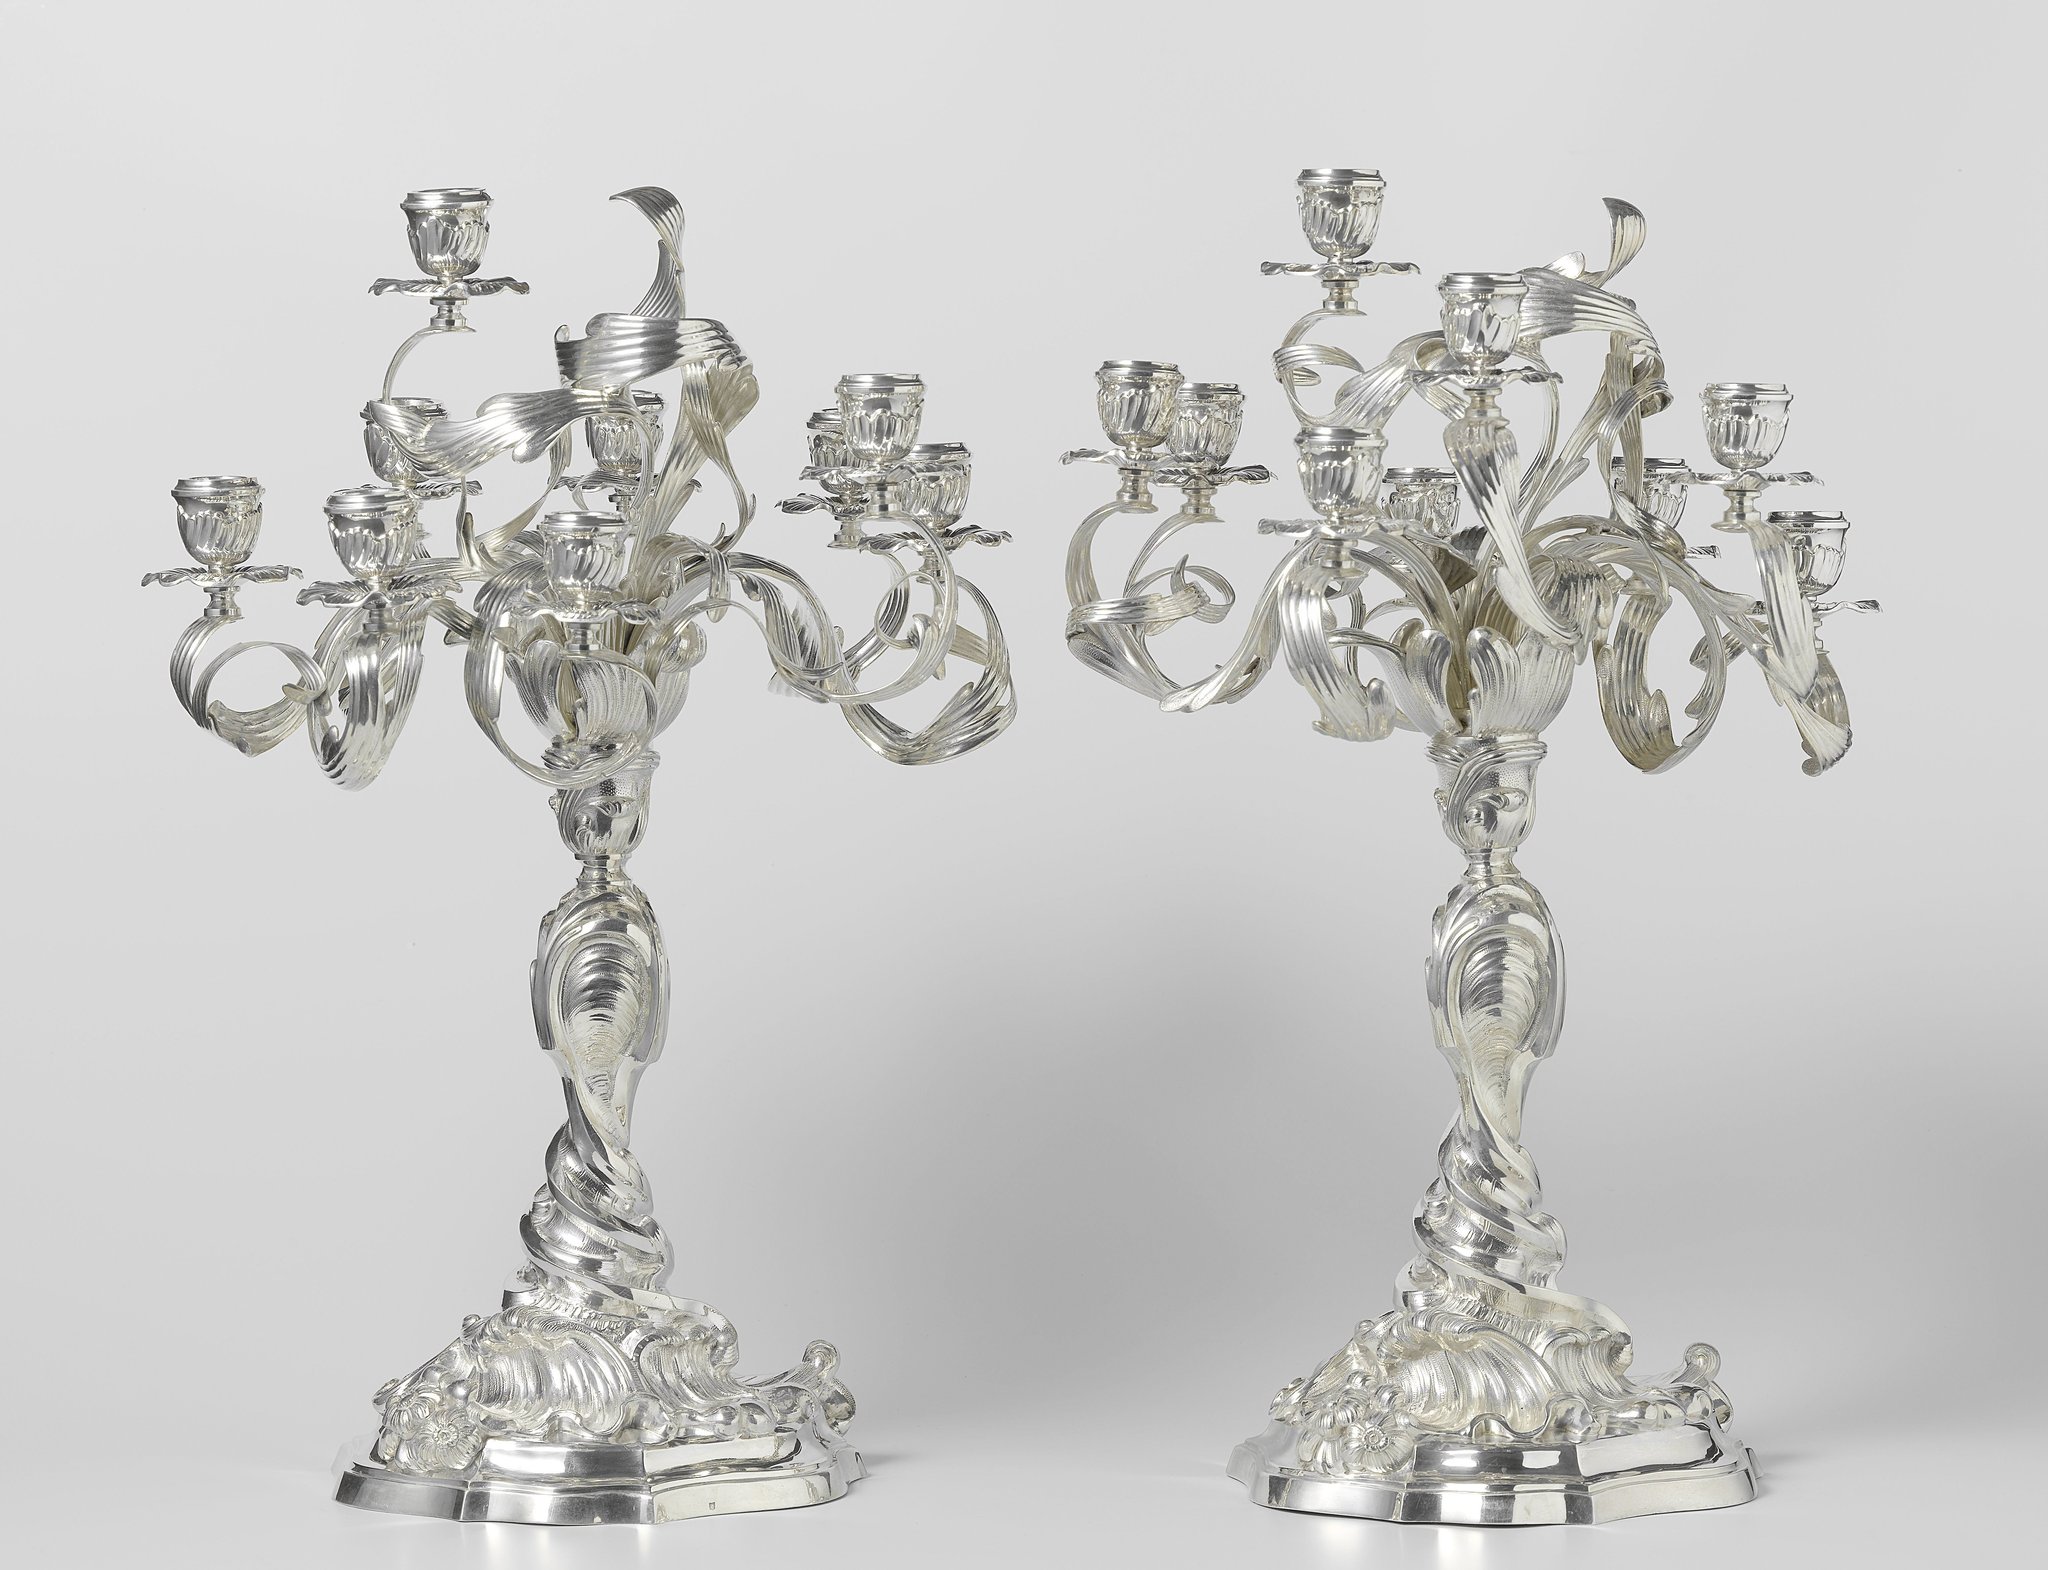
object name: candelabrum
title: Kandelaber met tien als langgerekte gekrulde bladeren vormgegeven armen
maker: maurits johannes lens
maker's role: designer, draughtsman, print maker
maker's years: 1829-1897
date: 1890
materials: silver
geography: utrecht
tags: ornament derived from plant forms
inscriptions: date letter: ‘F’, alloy mark, assay office mark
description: Two candelabra. Silver. Utrecht, Utrechtse Fabriek van zilverwerken C.J. Begeer, 1888 and 1890, designed by Maurits Johannes Lens.